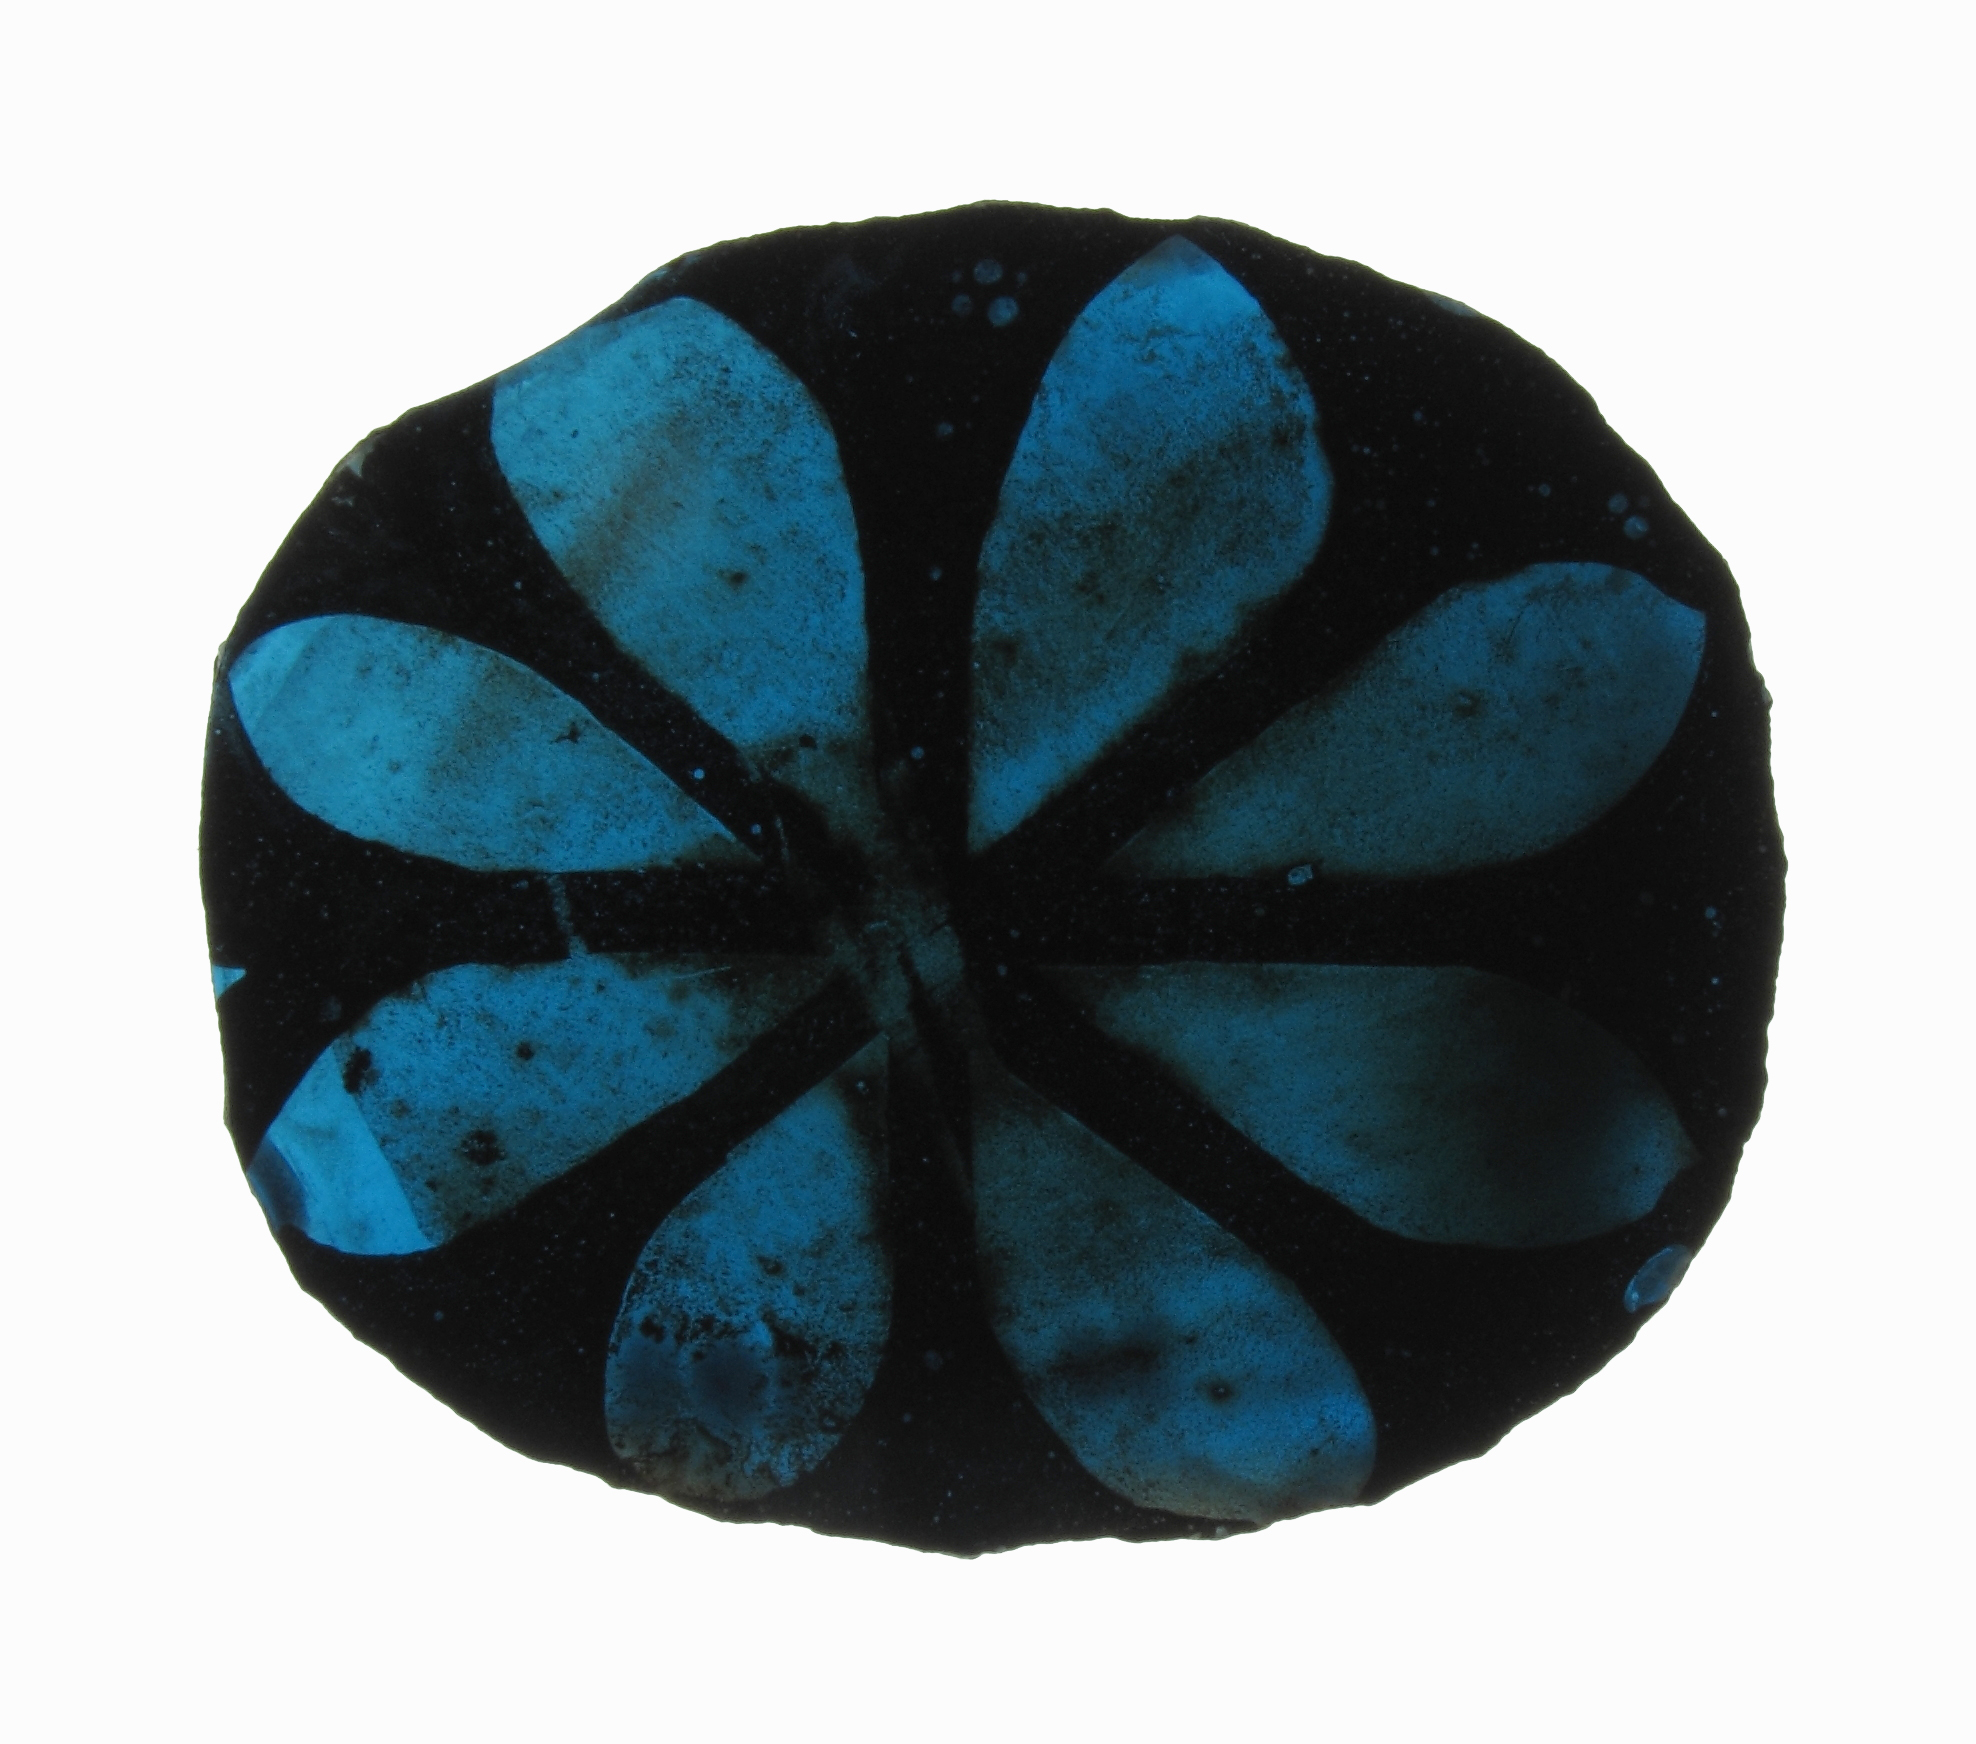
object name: fragment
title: Glass Fragment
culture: european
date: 1101-1700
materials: glass